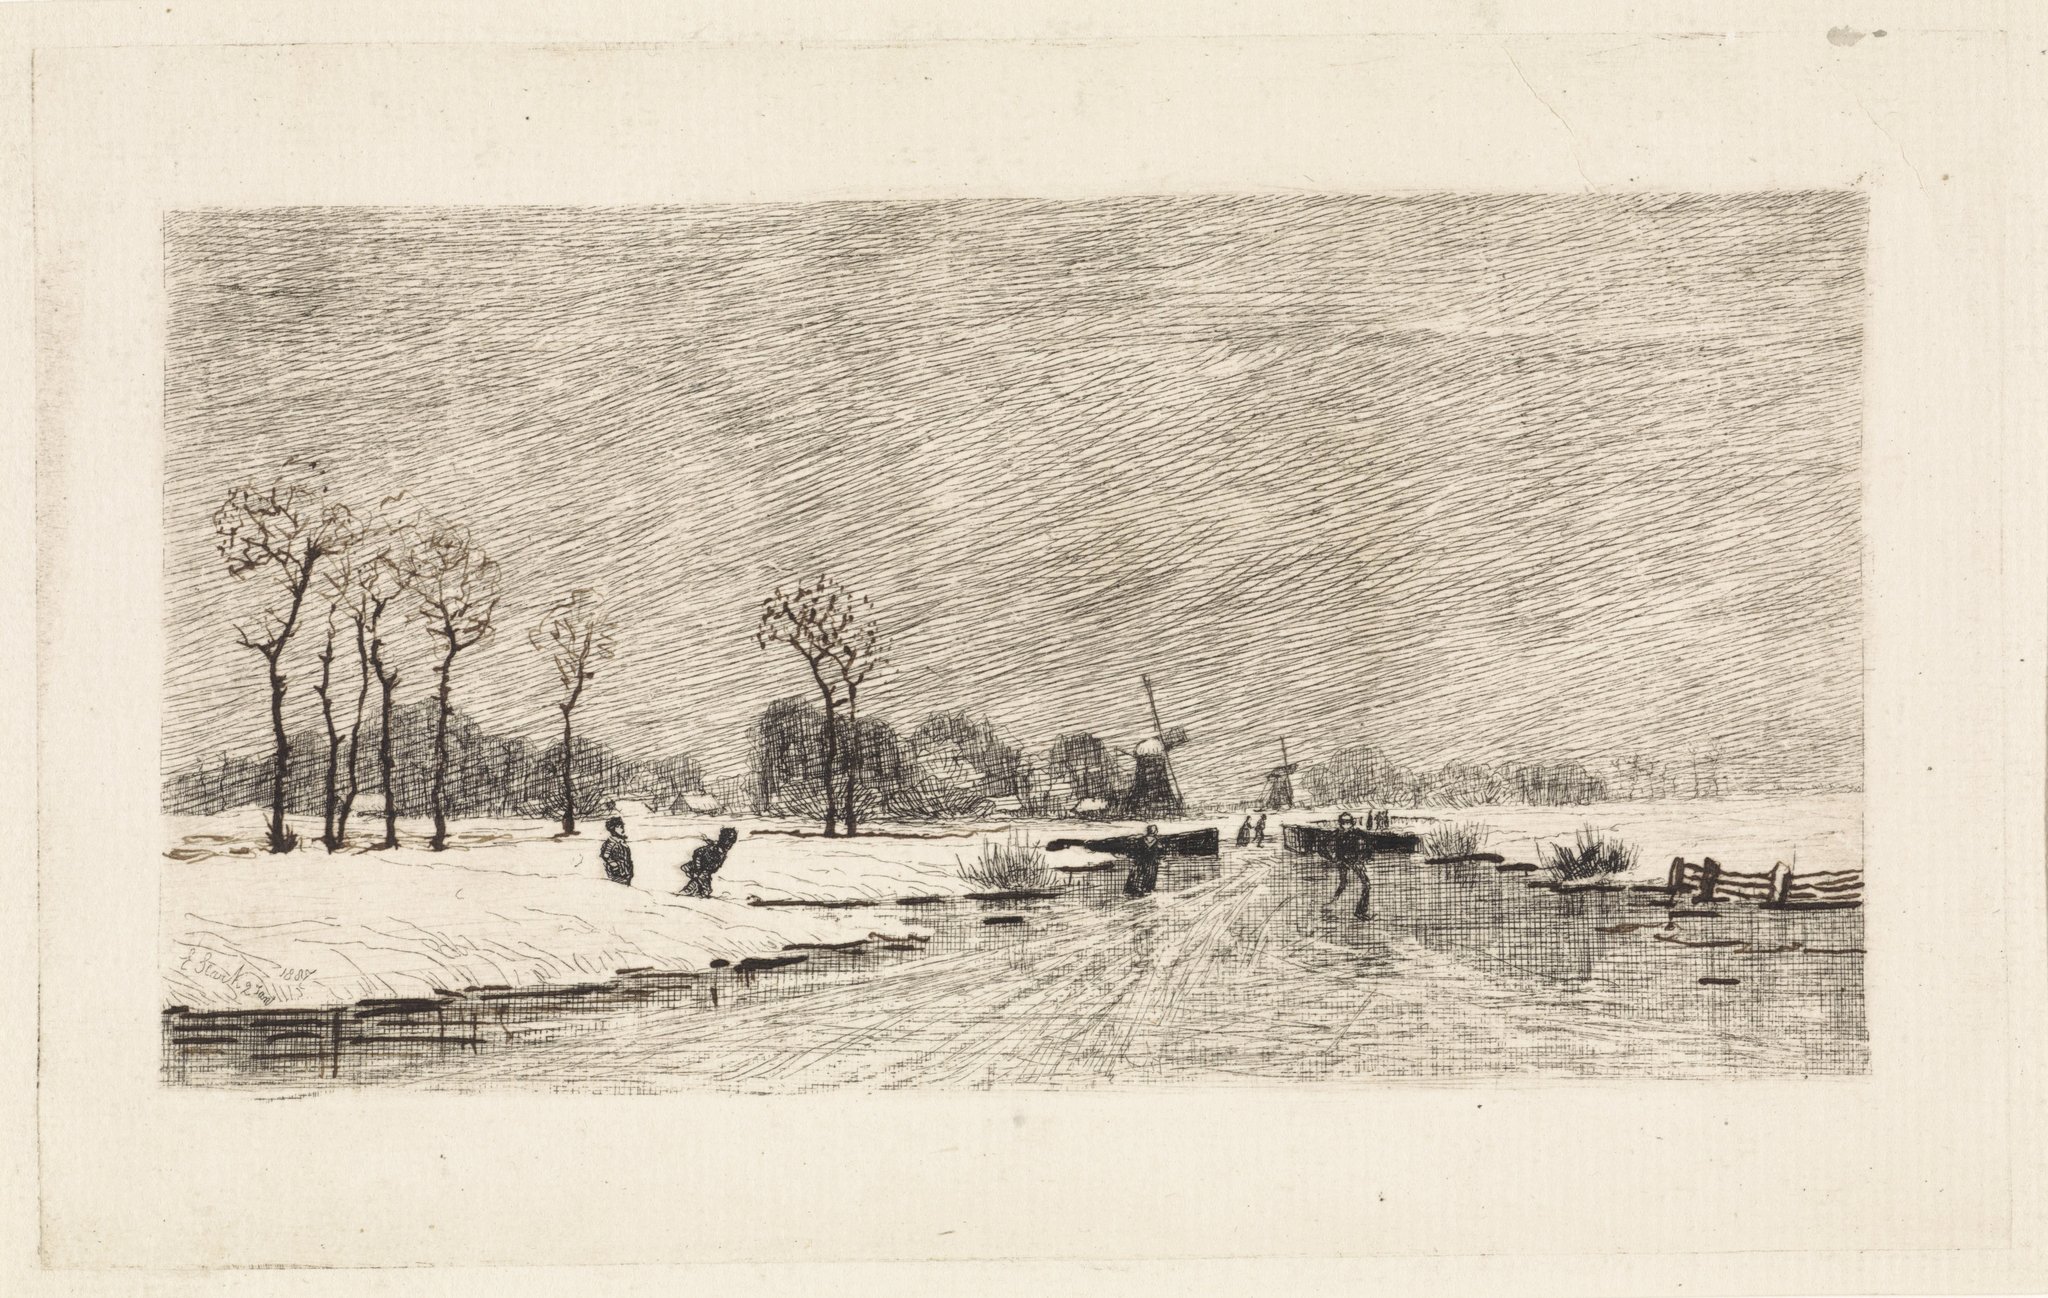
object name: print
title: Schaatsers in een Hollands landschap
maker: elias stark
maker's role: draughtsman, print maker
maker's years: 1849-1933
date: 1887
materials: paper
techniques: etching, pen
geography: nieuwer-amstel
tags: windmill in landscape, skates (winter sports)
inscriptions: collector's mark: Lugt 2228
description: Schaatsers op een vaart. Links komen twee schaatsers vanaf een slootje. In de verte twee molens.